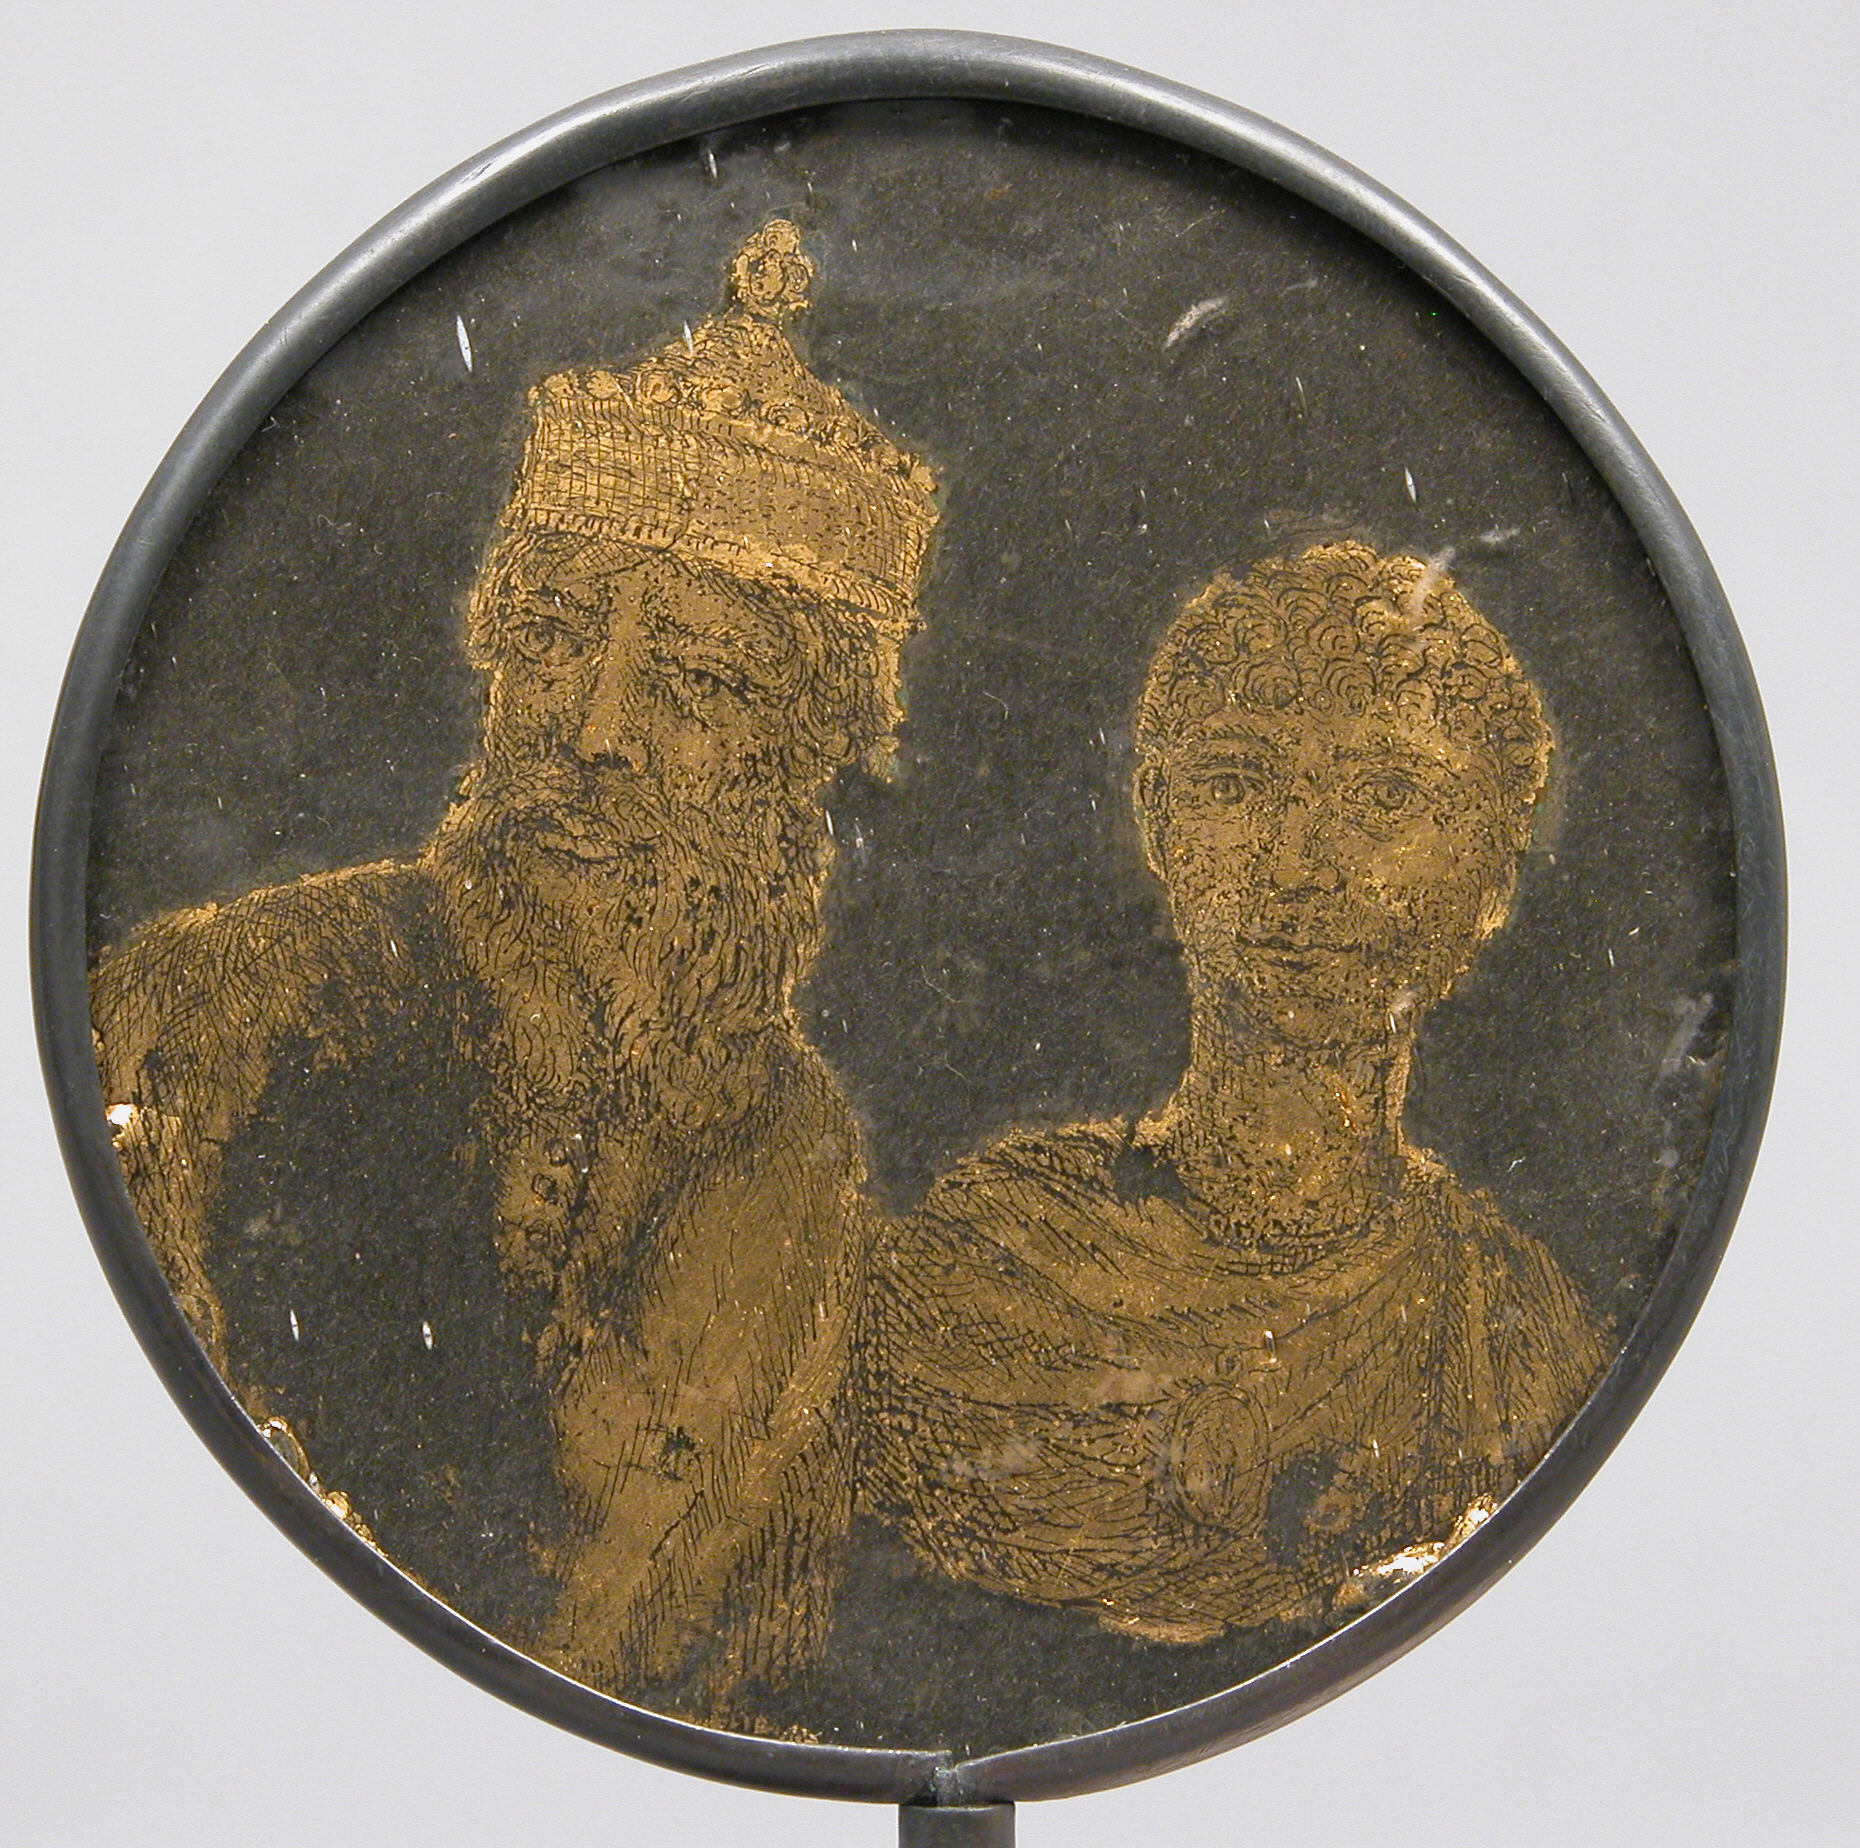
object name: medallion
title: Medallion with Double Portrait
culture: italian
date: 1701-1800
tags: men